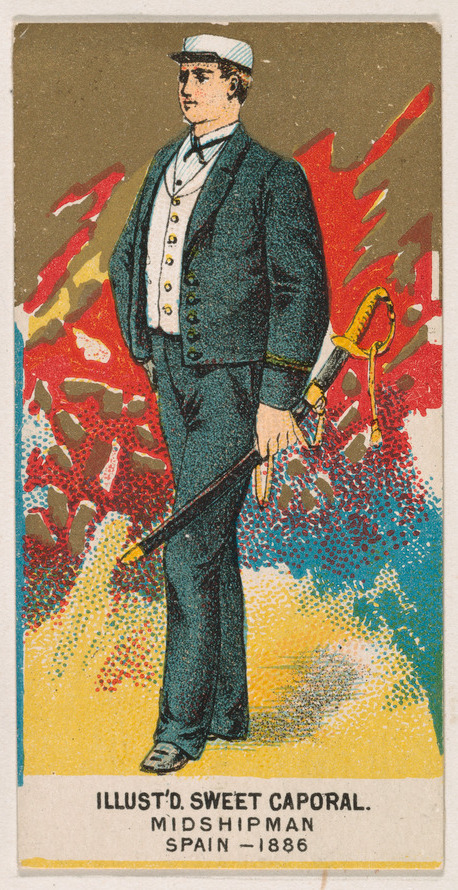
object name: print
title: Midshipman, Spain, 1886, from the Military Series (N224) issued by Kinney Tobacco Company to promote Sweet Caporal Cigarettes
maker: kinney brothers tobacco company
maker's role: publisher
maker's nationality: american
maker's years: 1869-2011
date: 1888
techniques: color lithograph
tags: military,men